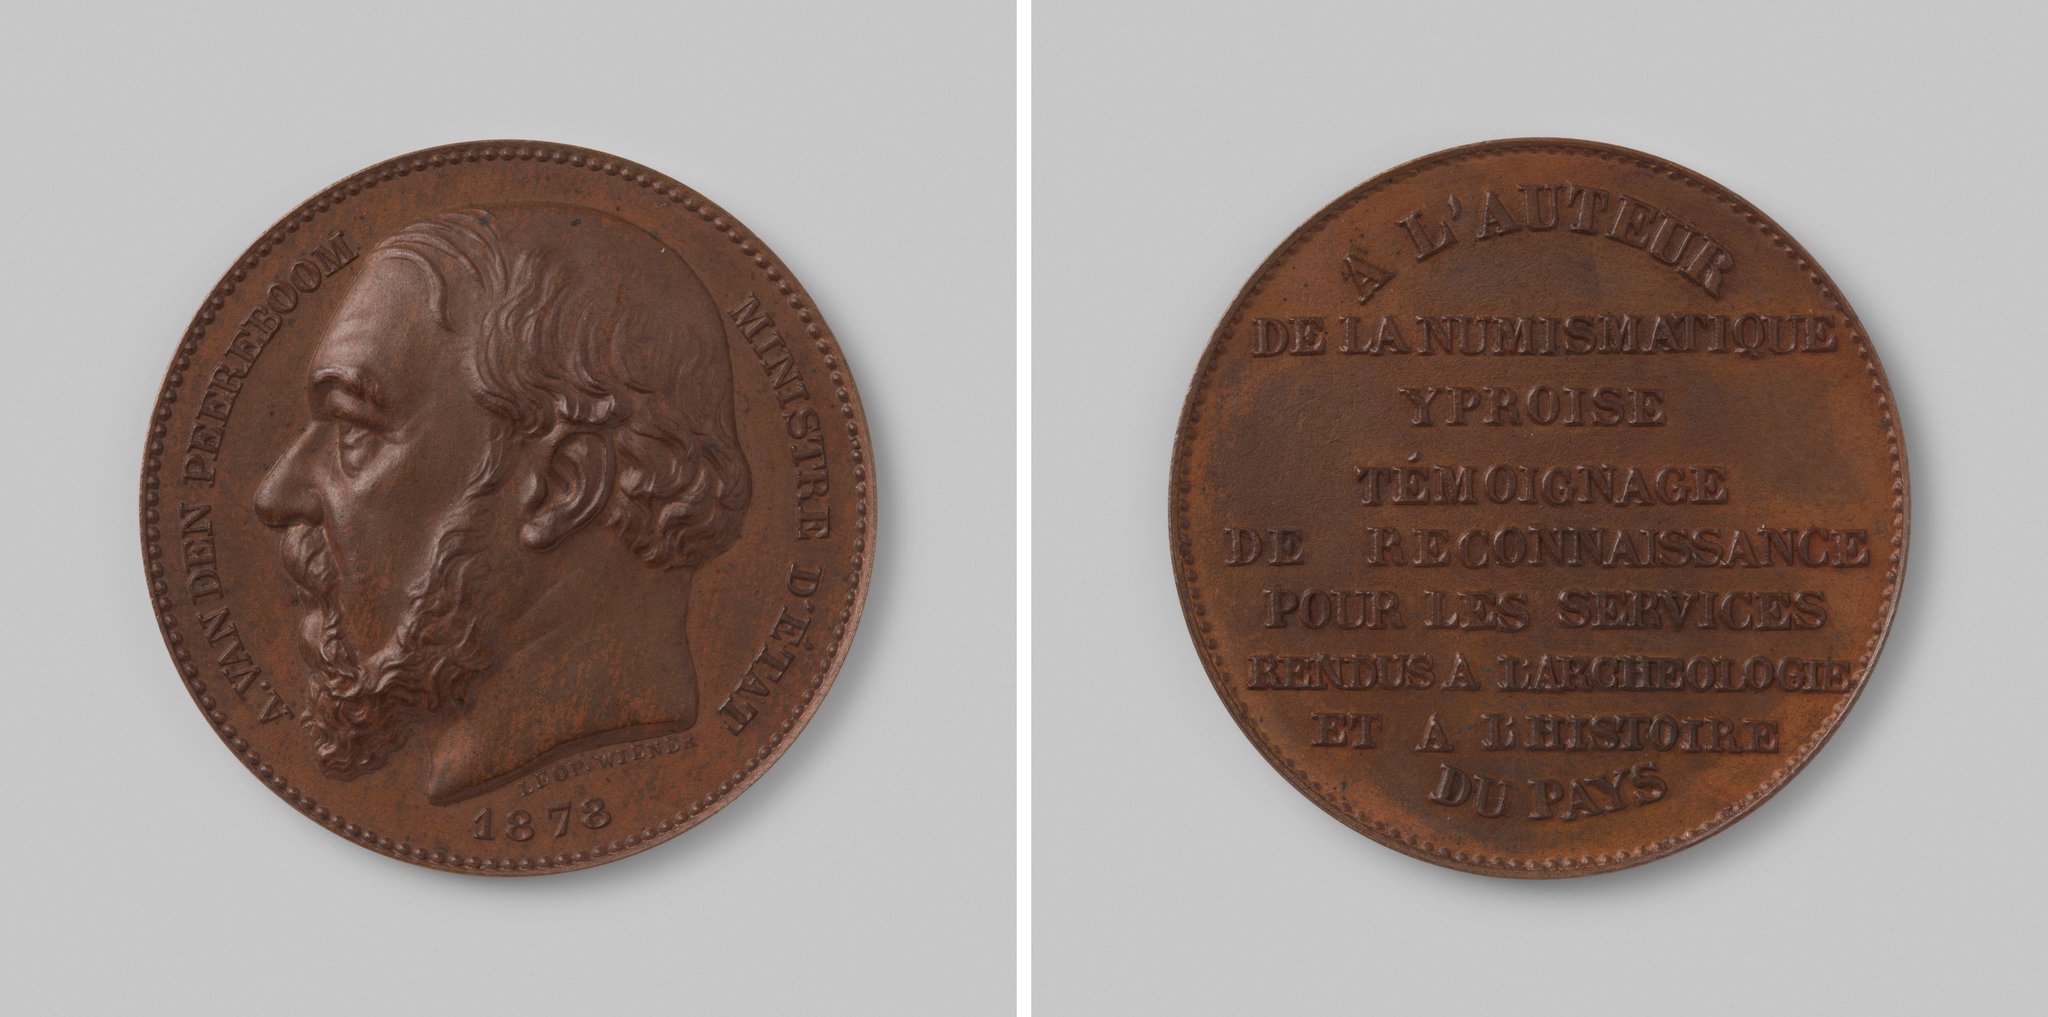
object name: medal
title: Alfons van der Peereboom, minister van Staat, bevorderaar van numismatiek, archeologie en geschiedenis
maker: leopold wiener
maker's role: sculptor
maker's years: 1823-1891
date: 1878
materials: bronze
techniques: striking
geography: brussels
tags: brussels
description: Bronzen penning. Voorzijde: borststuk man binnen omschrift. Keerzijde: opschrift binnen omschrift